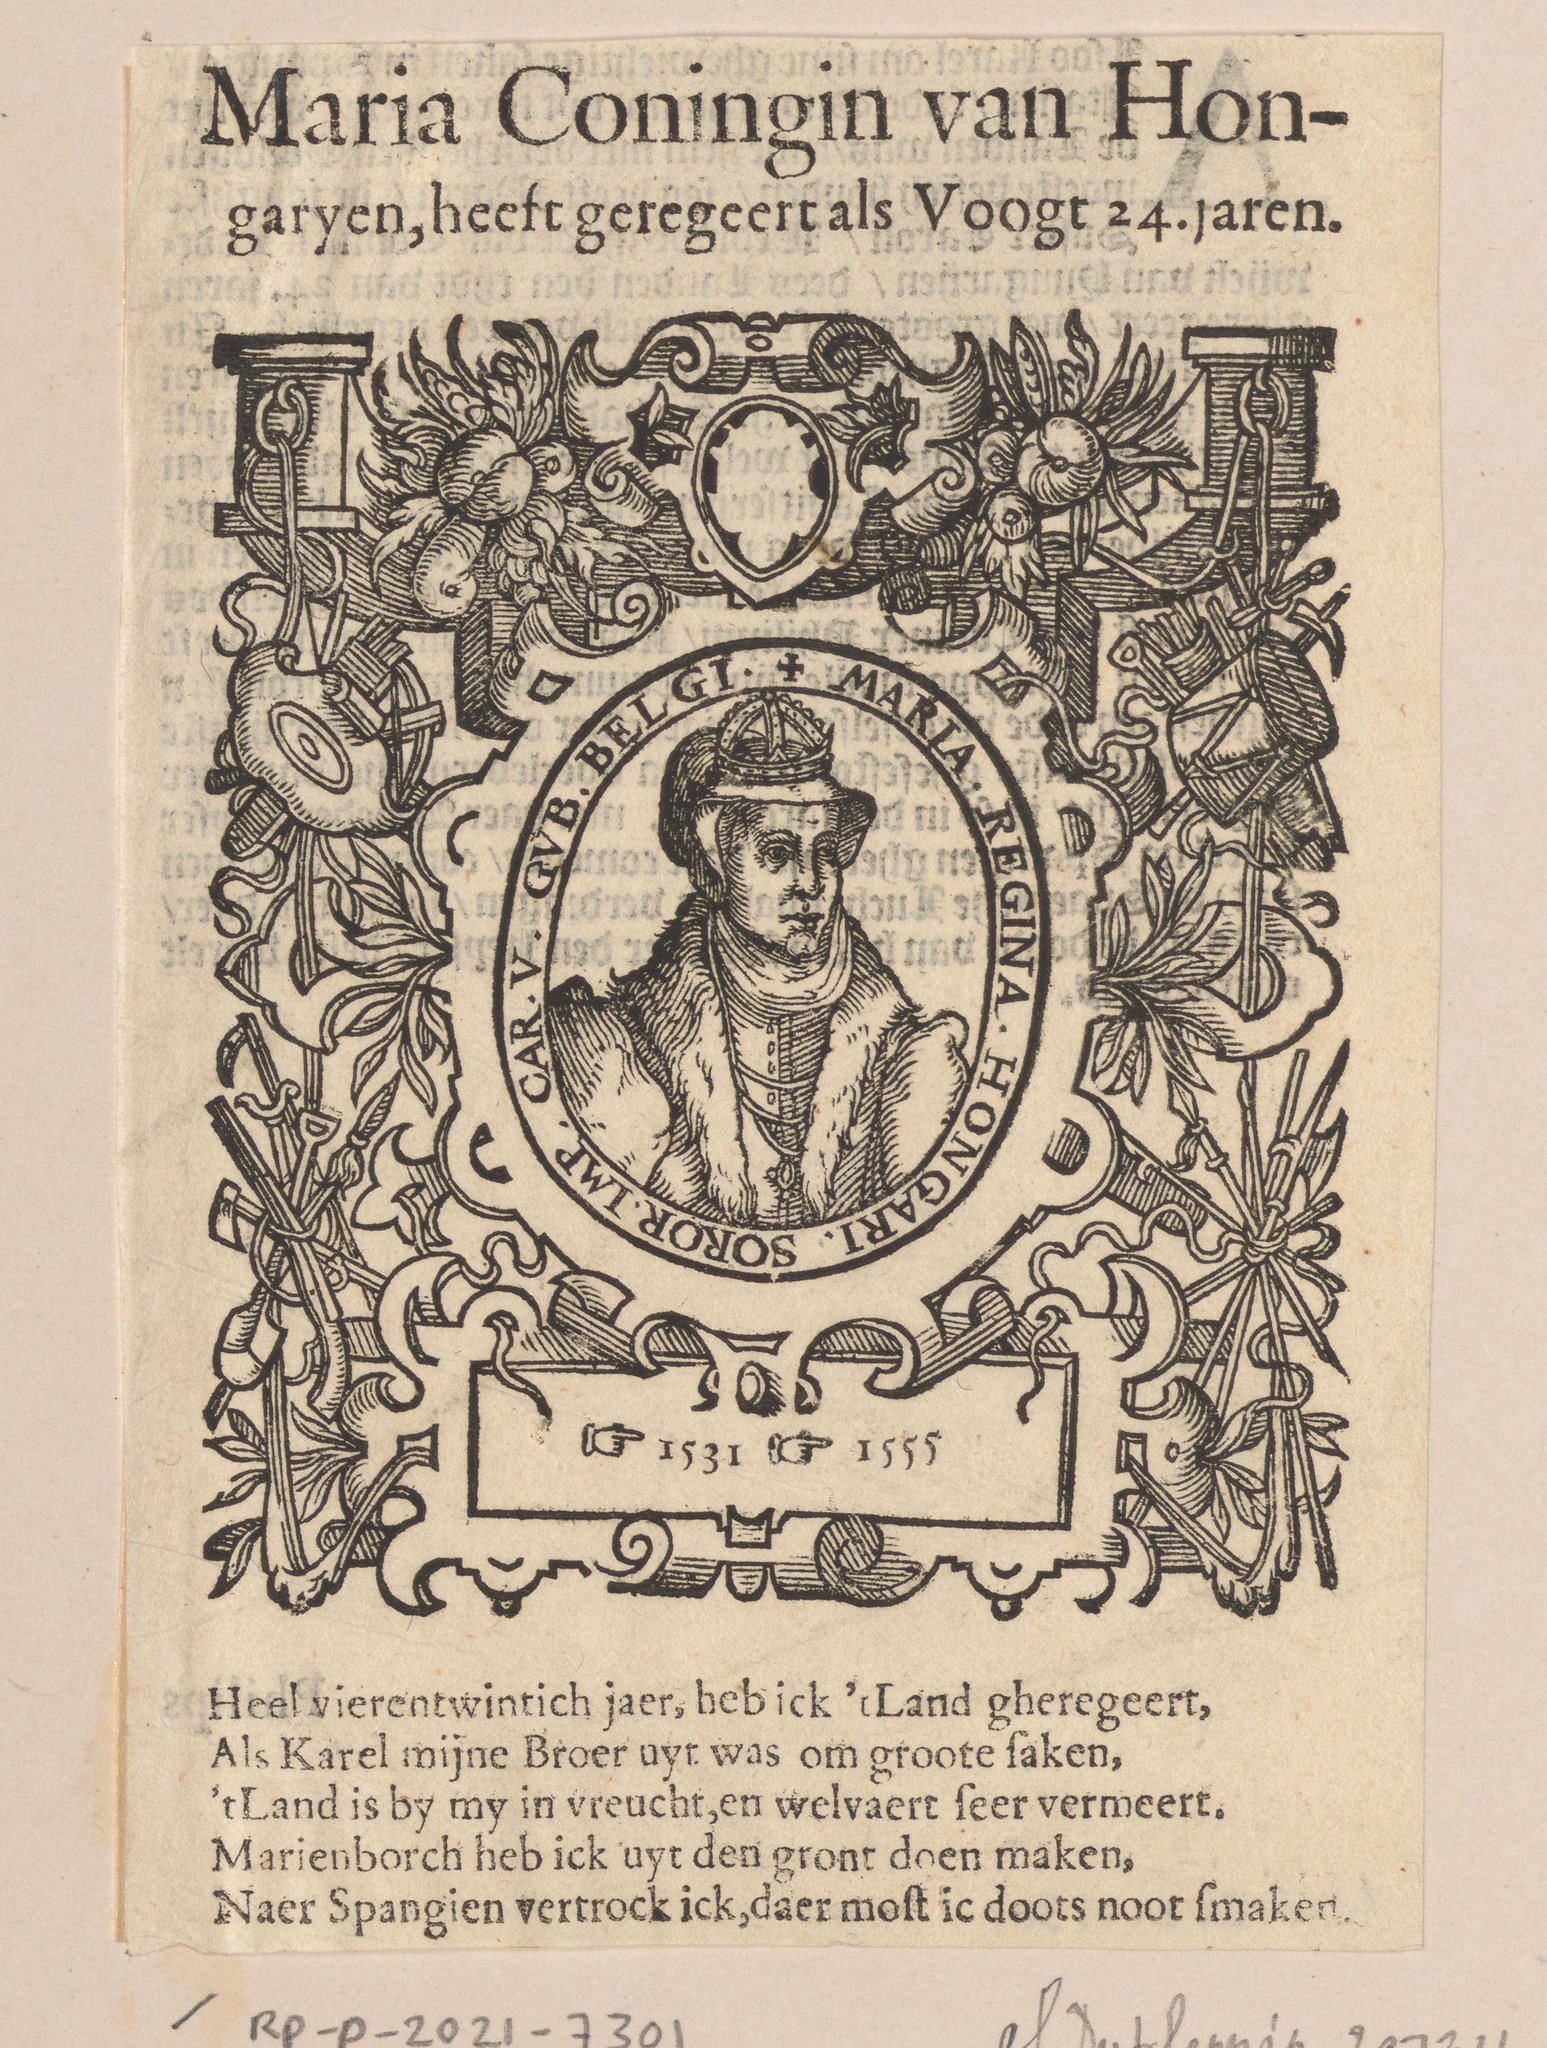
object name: print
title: Portret van Maria van Hongarije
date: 1636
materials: paper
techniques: letterpress printing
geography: amsterdam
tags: brussels, maria van hongarije (landvoogdes der nederlanden), historical persons - bb - woman, ornament derived from architectural details, regent, substitute ruler; viceroy - bb - female ruler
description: Prent uit: Scriverius, Petrus. Beschrivinge van Out Batavien (...). Amsterdam: Jan Cloppenburg, 1636. Prent eerder gebruikt in publicaties uit 1606 en 1609, zie Van Someren.